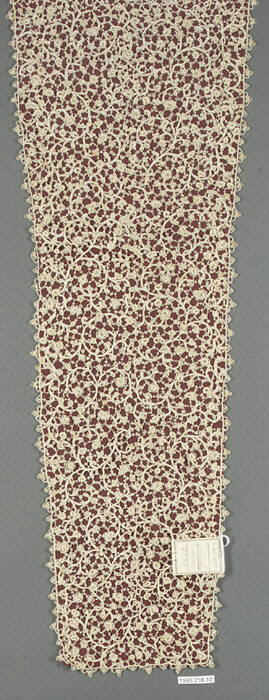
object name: panel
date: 1601-1700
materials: linen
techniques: lace